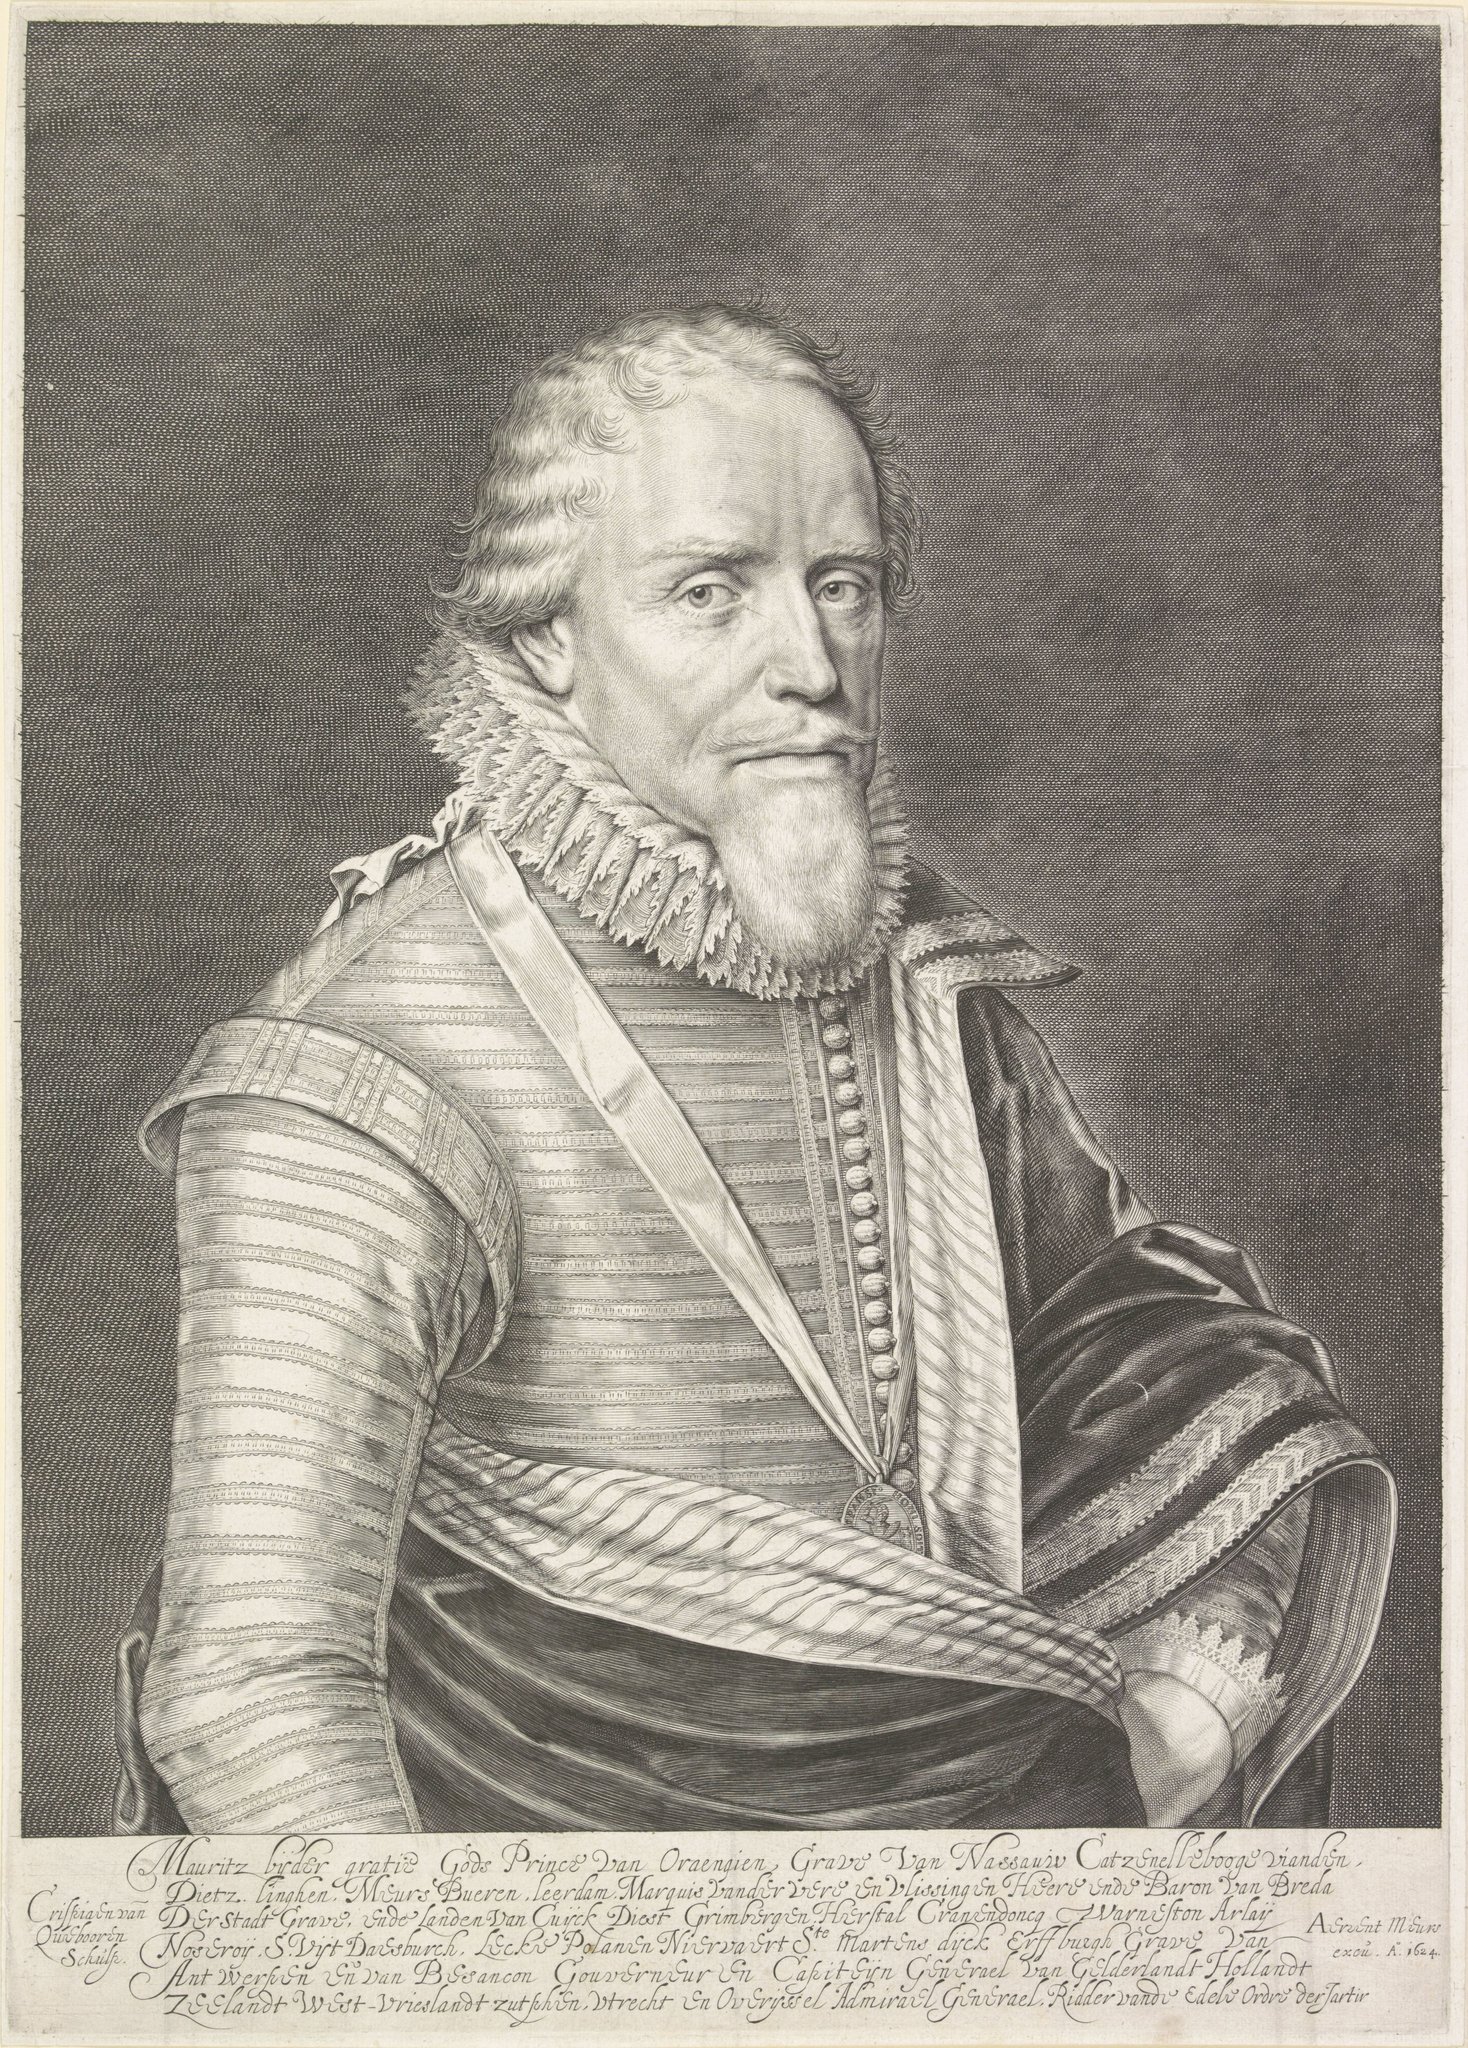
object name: print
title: Portret van Maurits, prins van Oranje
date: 1624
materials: paper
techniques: engraving, etching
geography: the hague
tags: maurice (prince of orange), knighthood order (garter) - insignia of a knighthood order, e.g.: badge, chain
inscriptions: date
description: De hier vermelde titel verwijst naar de hoogst verkregen titel van de geportretteerde, niet per se naar de titel die de geportretteerde op deze voorstelling draagt.